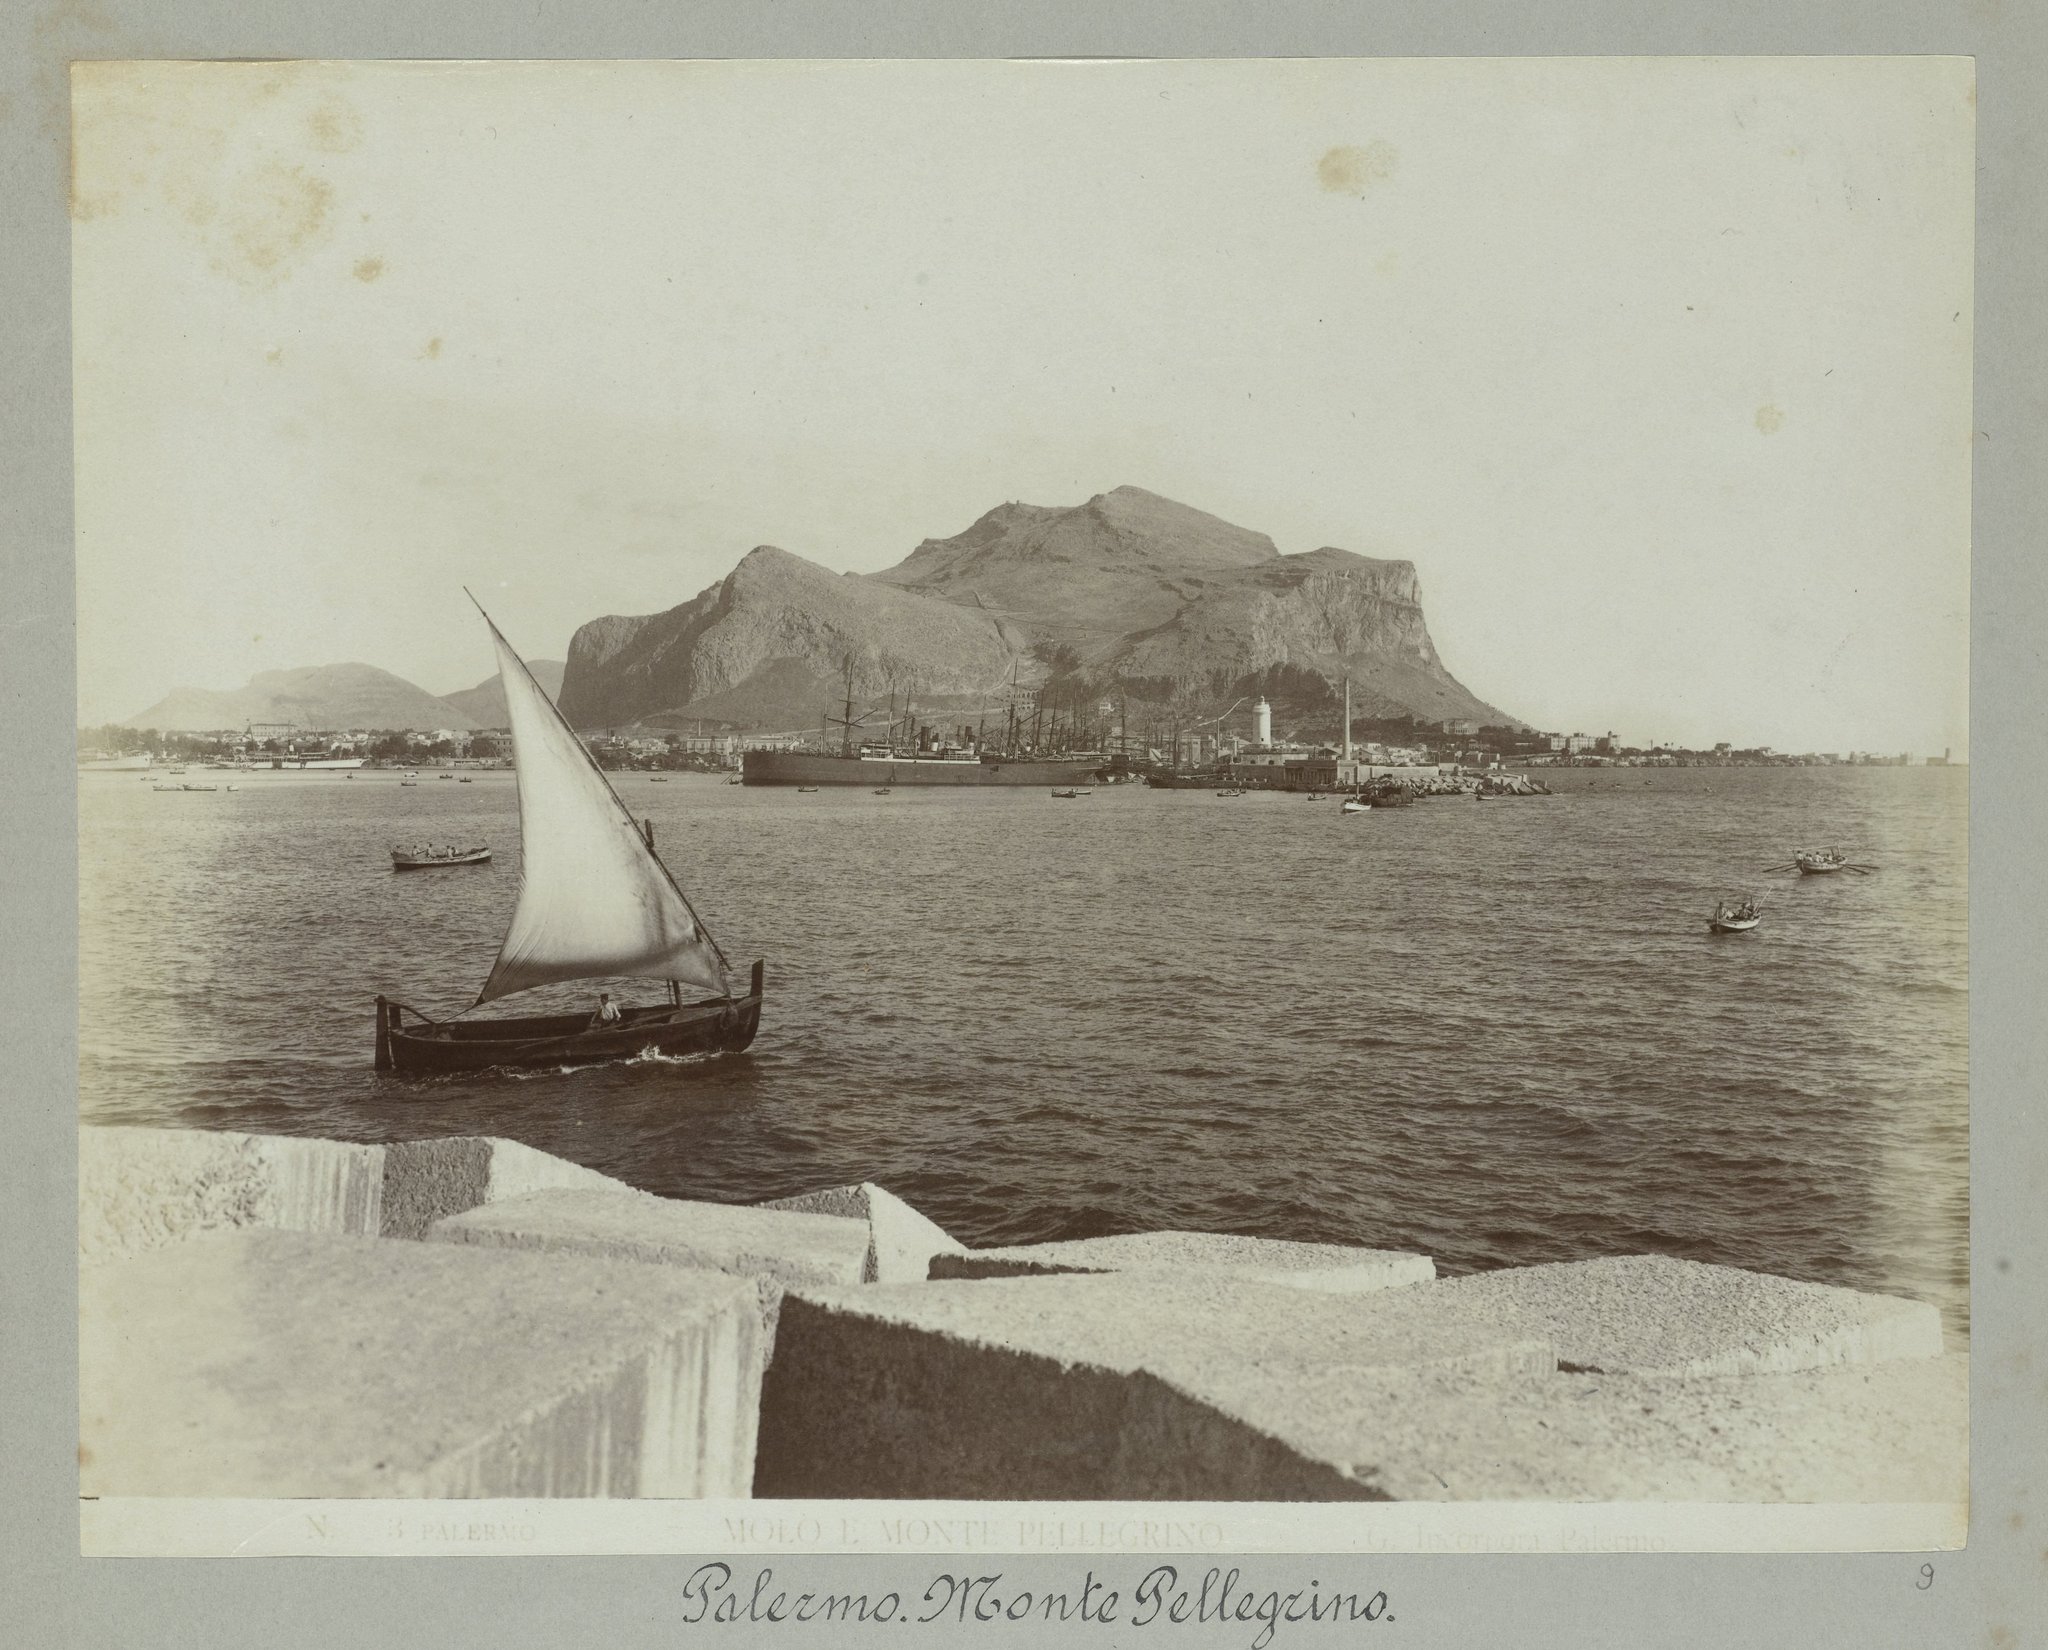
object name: photograph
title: Palermo Monte Pellegrino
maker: giuseppe incorpora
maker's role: fotograaf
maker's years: 1834-1914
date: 1893-1903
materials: cardboard, photographic support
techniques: albumen print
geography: netherlands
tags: palermo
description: Uitzicht op de Monte Pellegrino in Palermo vanaf het water.